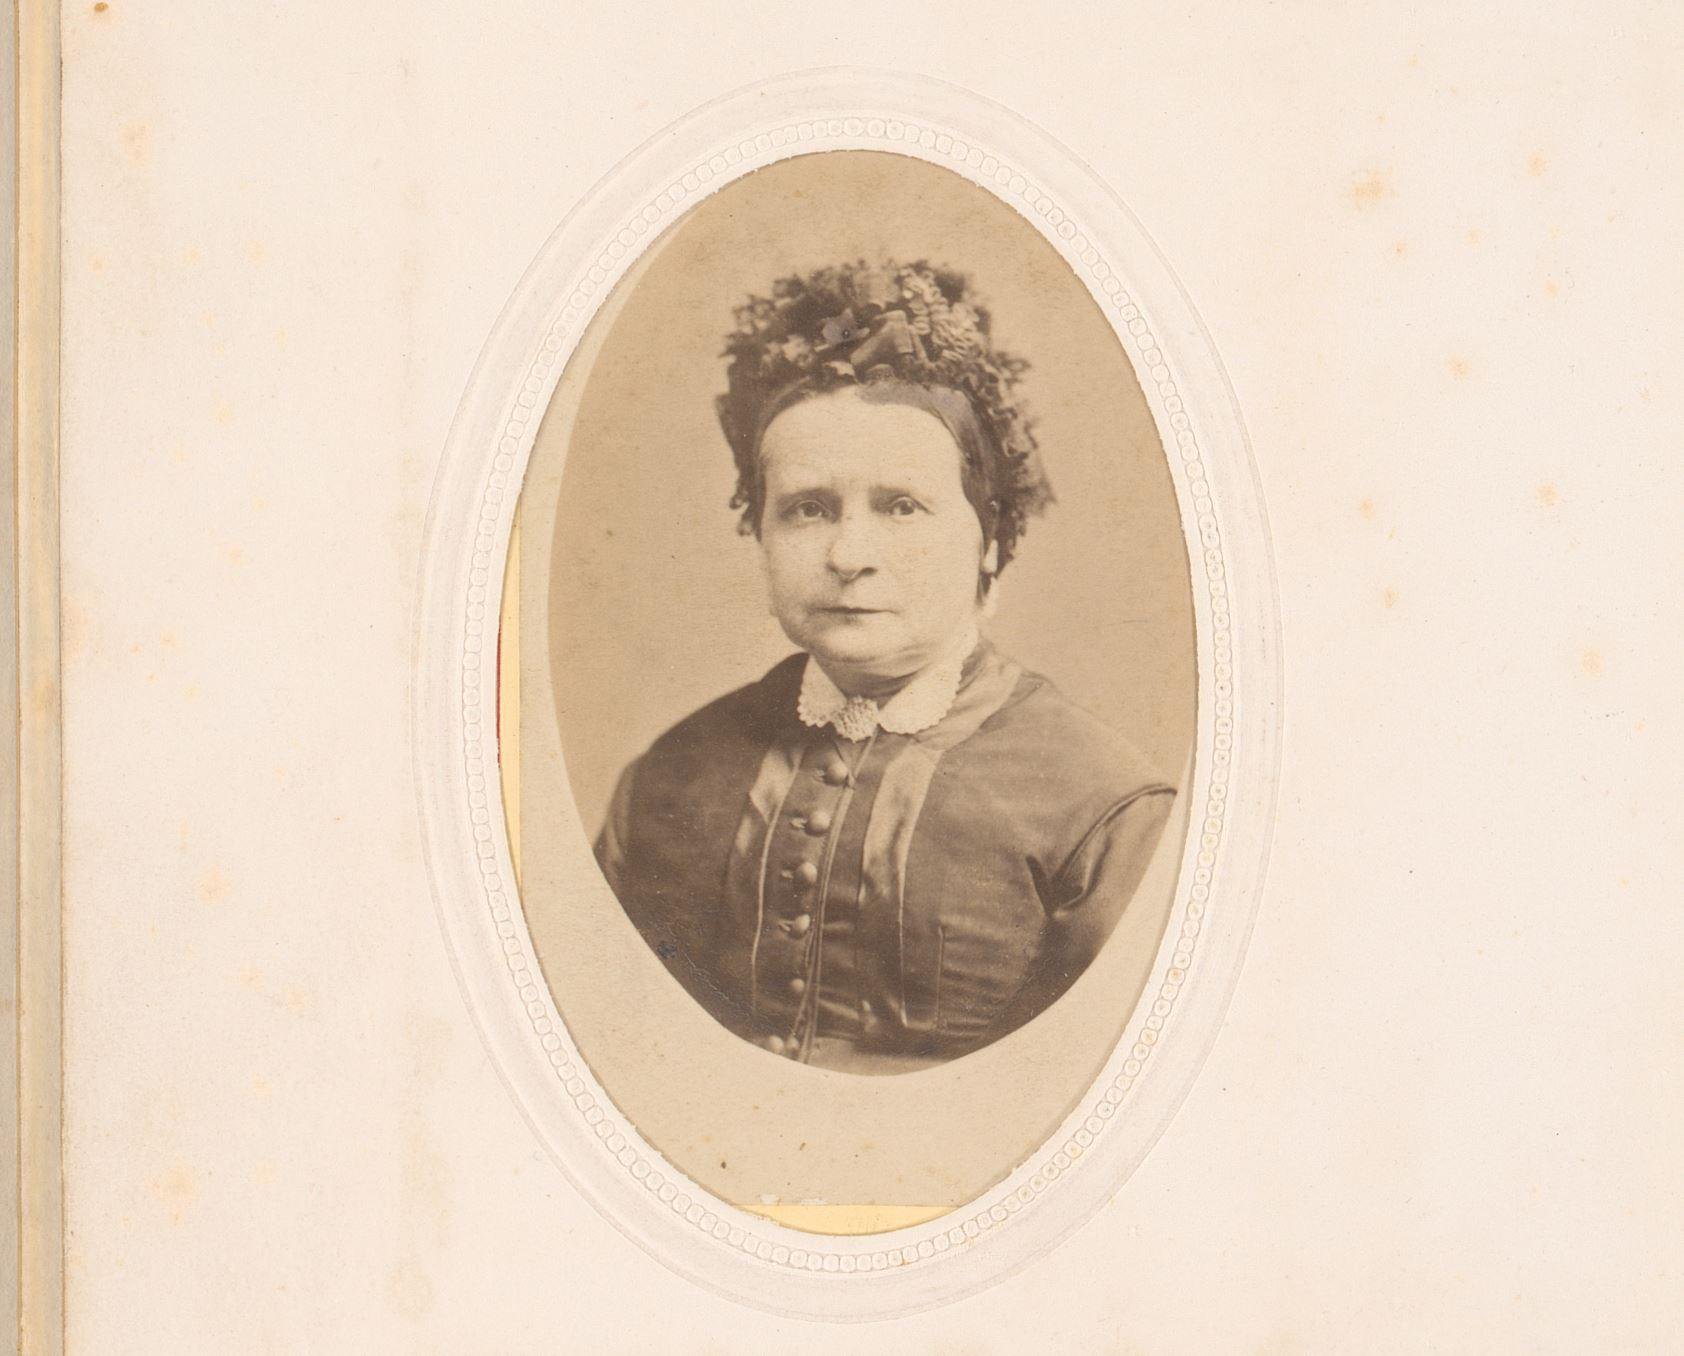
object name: photograph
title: Portret van een vrouw met muts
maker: friedrich julius von kolkow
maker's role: fotograaf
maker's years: 1839-1914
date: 1873-1900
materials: cardboard, photographic support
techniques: albumen print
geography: groningen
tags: historical persons - bb - woman, head-gear: cap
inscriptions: inscription: ‘WERELD-TENTOONSTELLING/ WEENEN/ VERDIENST-MEDAILLE/ (...) Fr. Jul. von Kolkow/ Hof-Photograph/ Z.K.H. Prins Hendrik der Nederlanden./ Groningen.’, annotation: ‘Moeder Bil[...]’